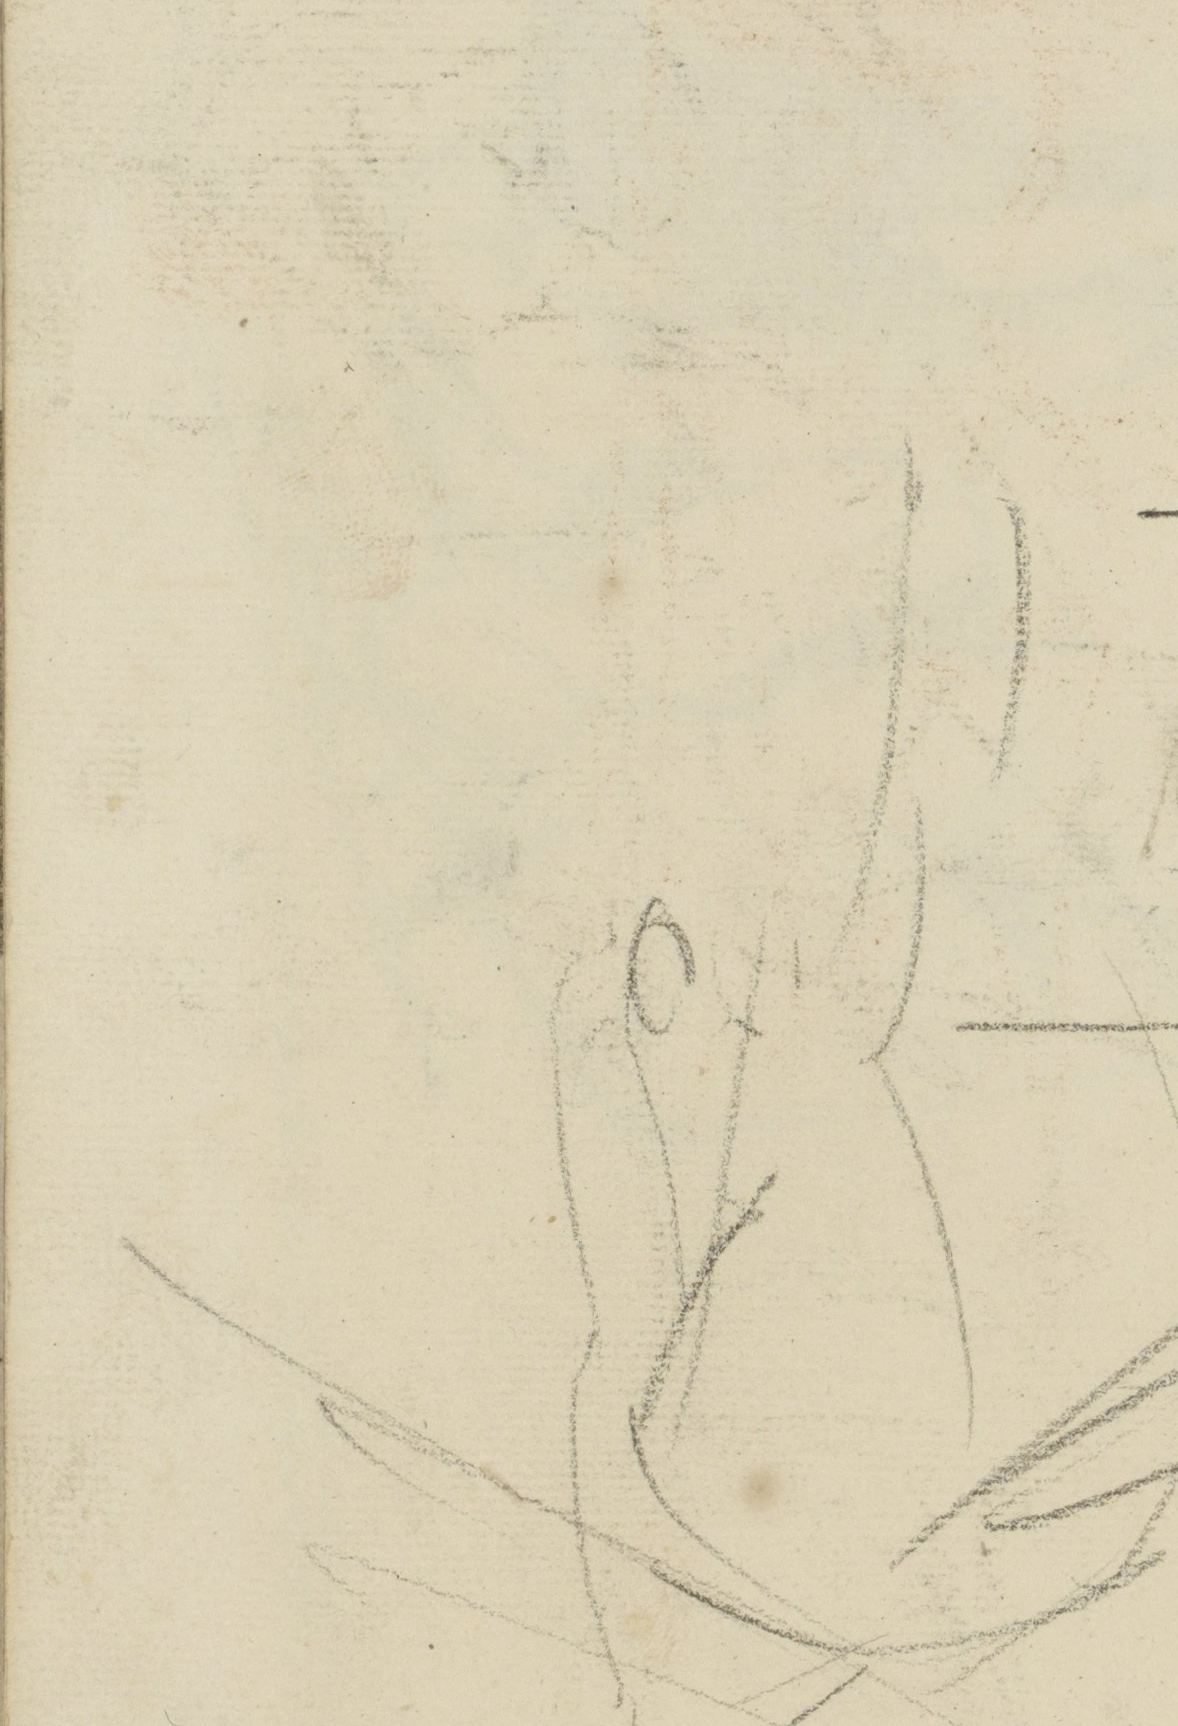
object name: sketchbook leaf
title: Paard en een perspectiefstudie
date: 1904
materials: chalk, paper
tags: horse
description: Pagina 25 uit een schetsboek met 14 bladen.